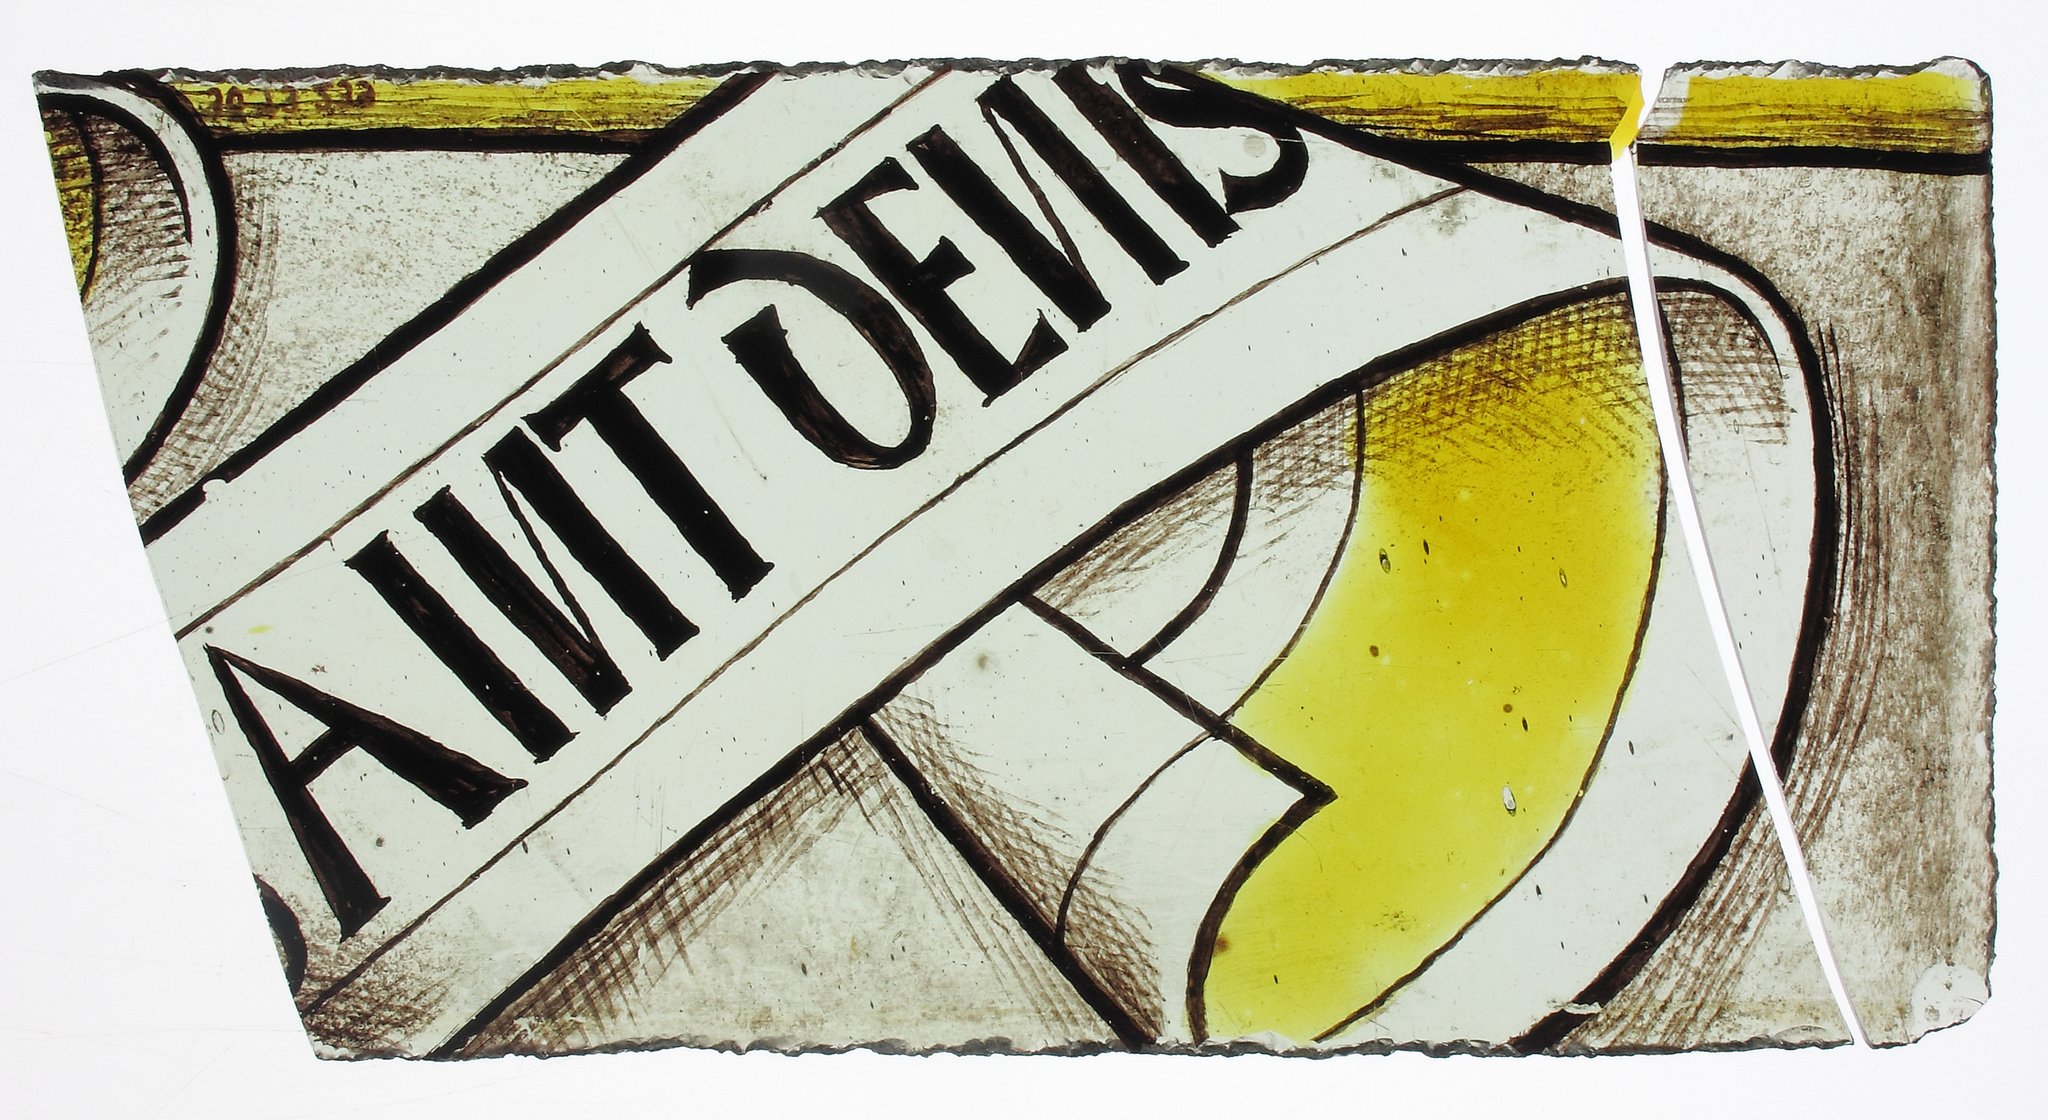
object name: fragment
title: Glass Fragment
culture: european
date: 1401-1600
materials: glass, paint, pigment